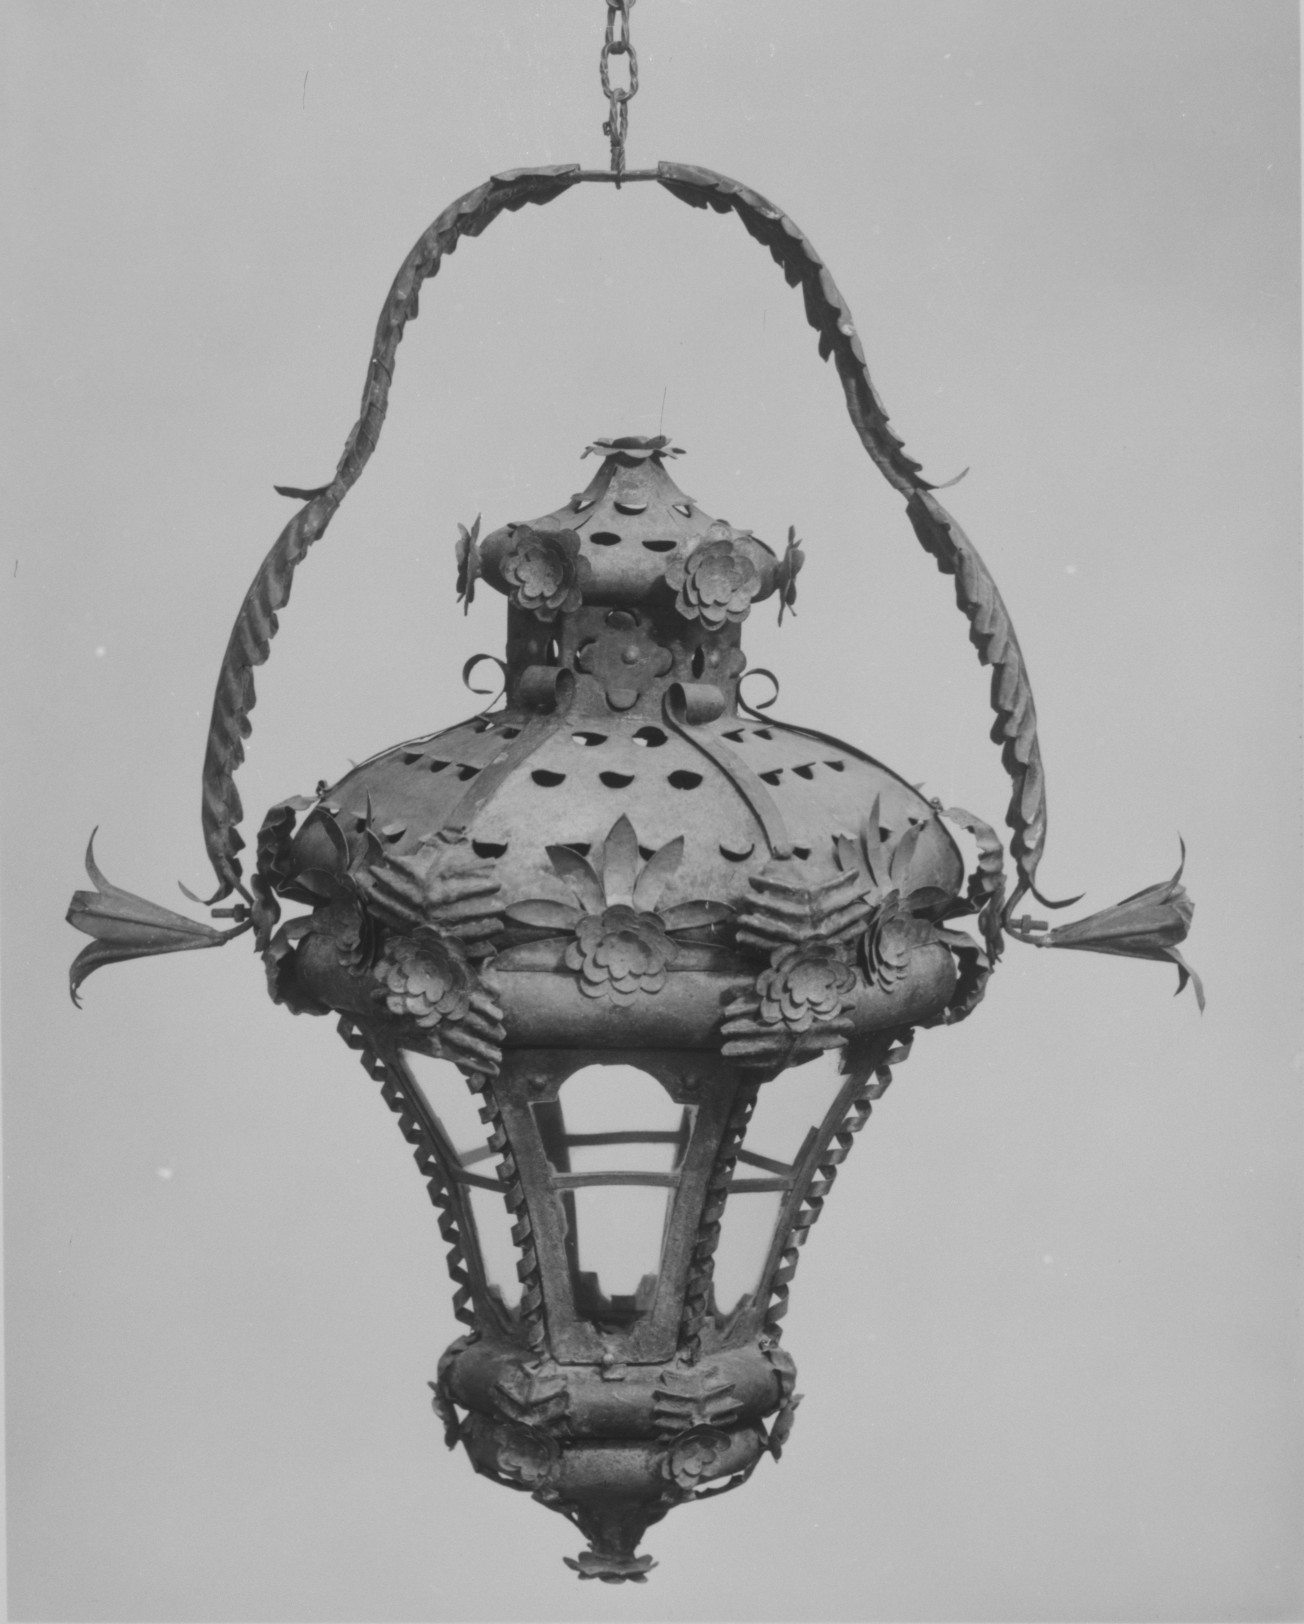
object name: lantern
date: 1701-1800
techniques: gilding, painting